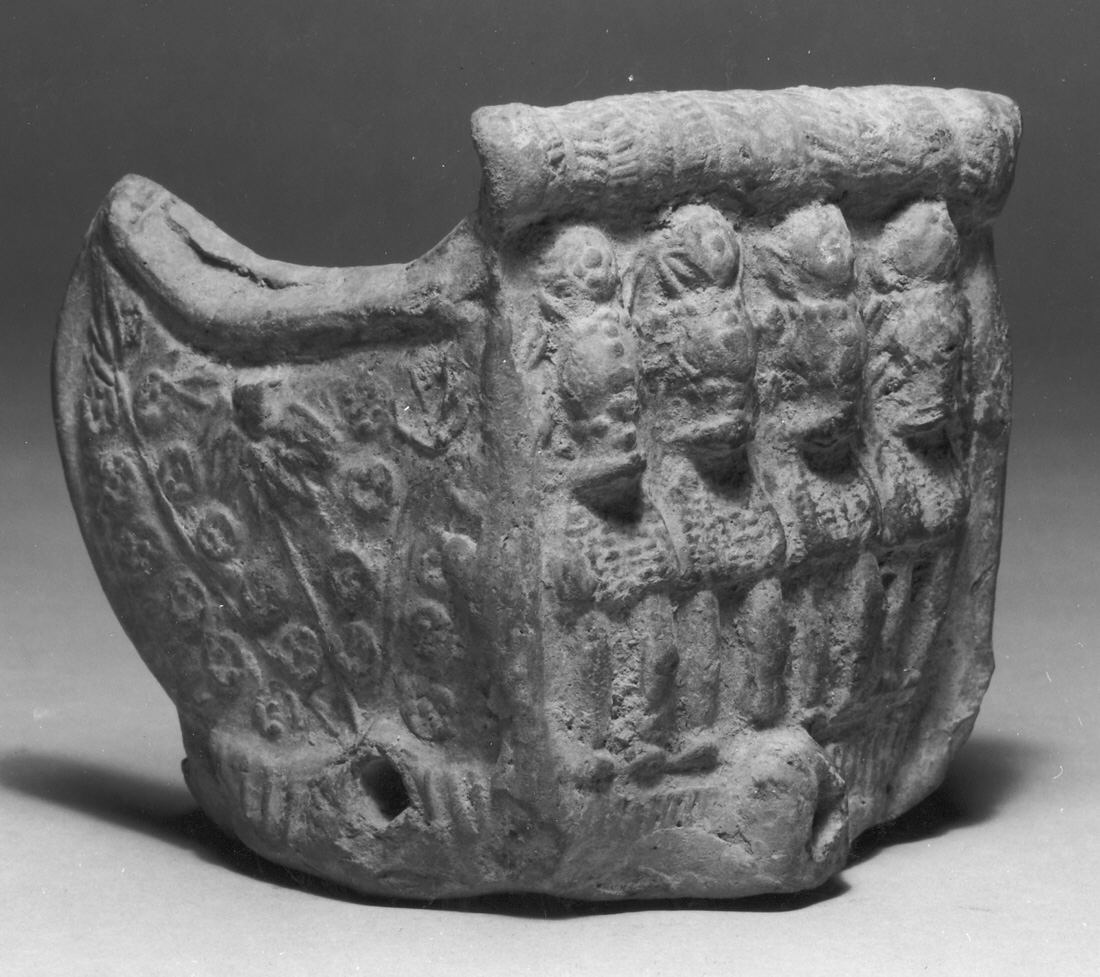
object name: cart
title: Toy Cart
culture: indian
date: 100 BCE-100 CE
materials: terracotta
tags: shunga,carts,toys